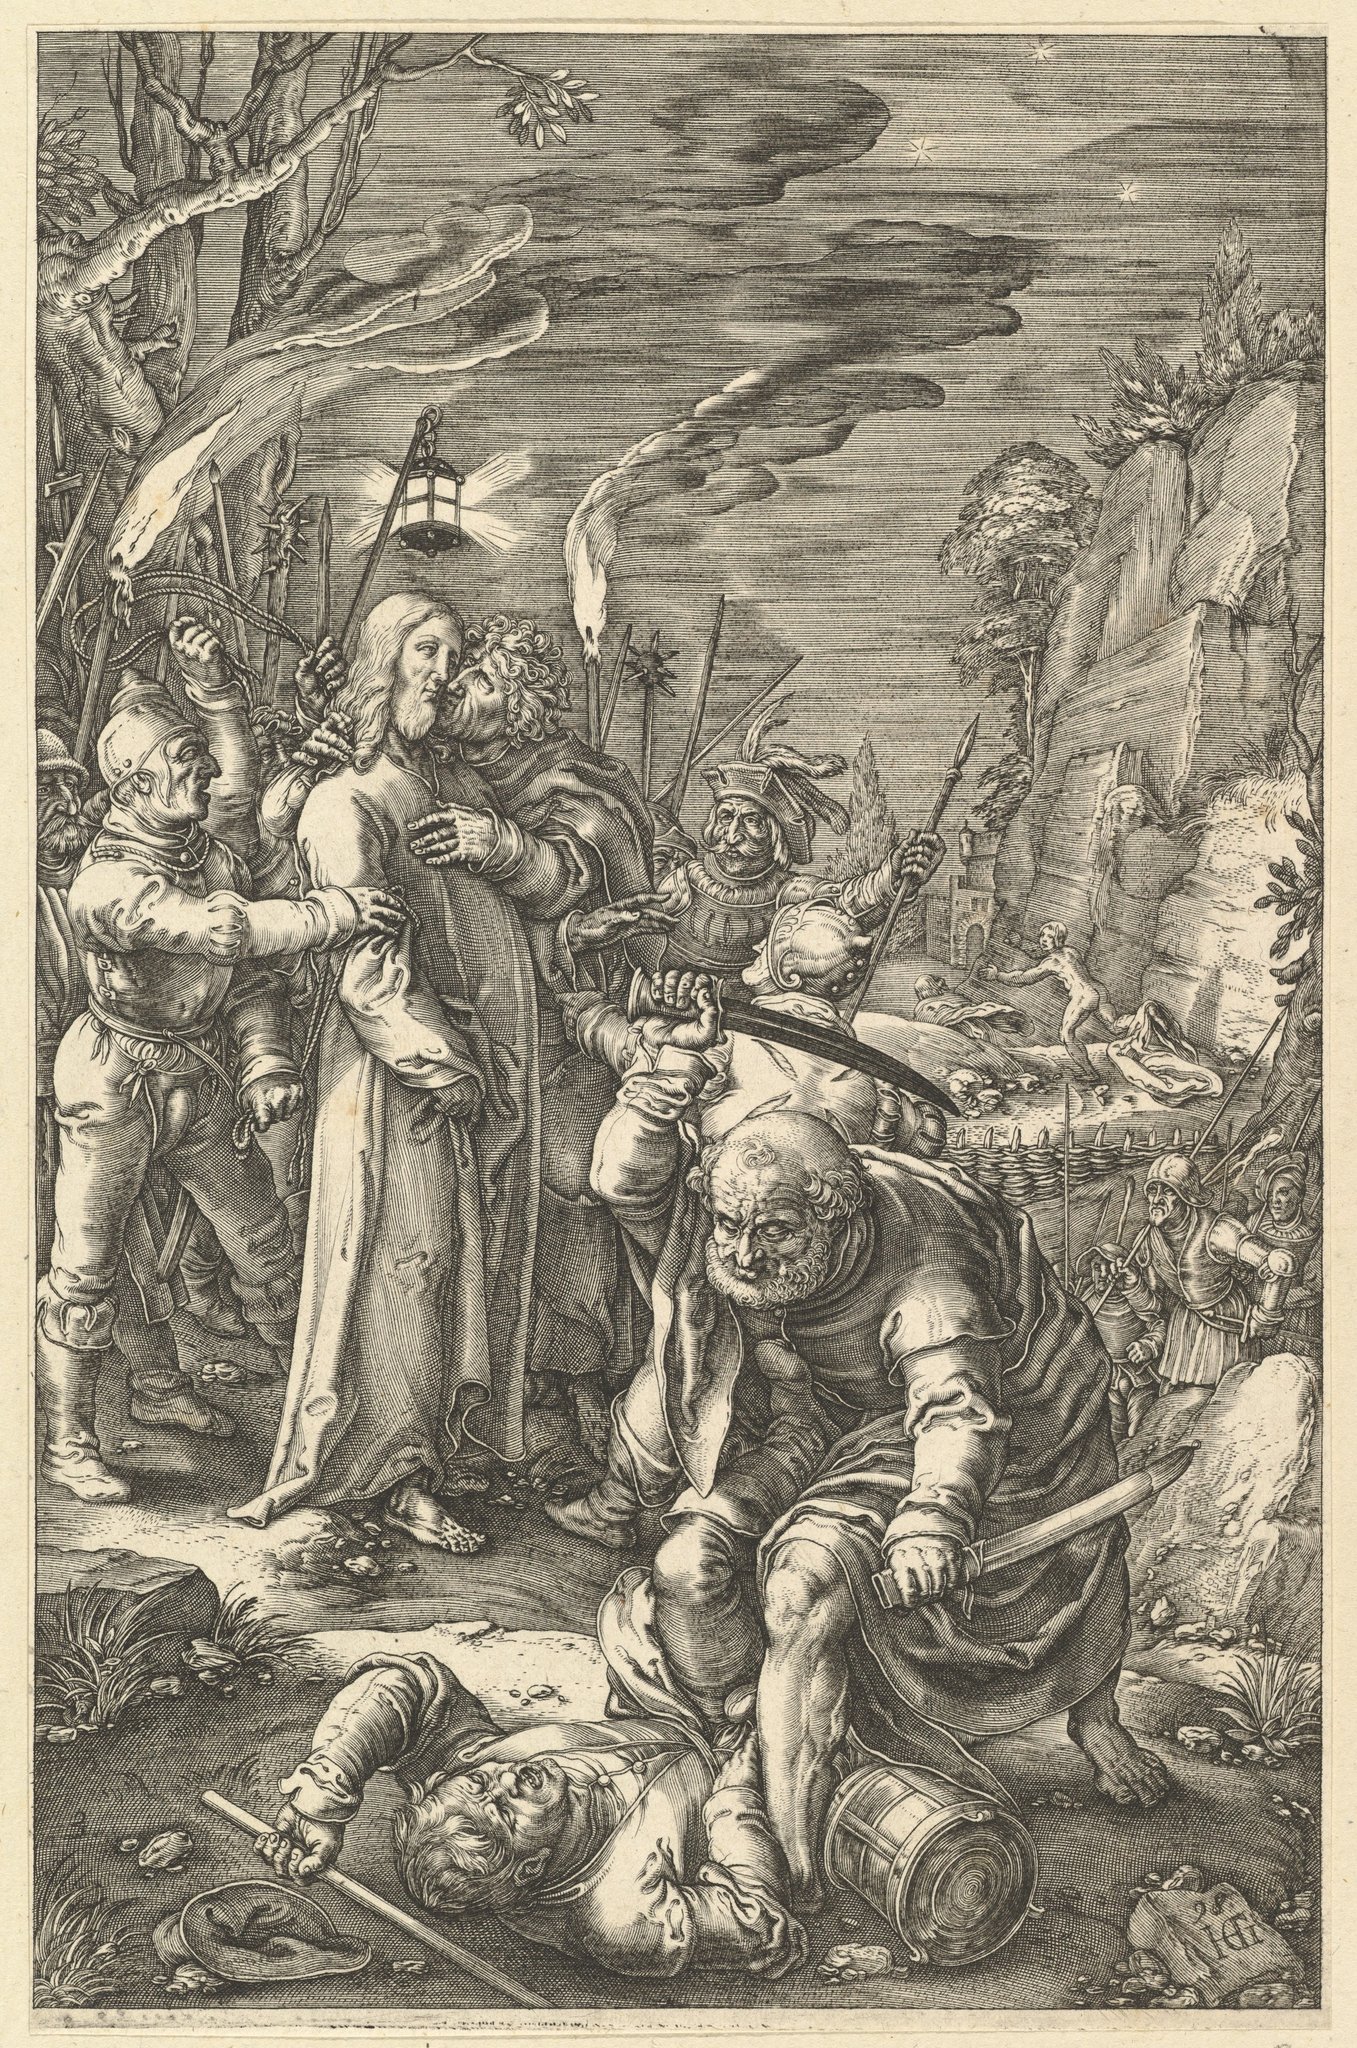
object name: print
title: The Betrayal of Christ, from "The Passion of Christ"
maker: Anonymous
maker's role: artist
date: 1598-1617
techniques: engraving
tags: soldiers,daggers,apostles,jesus